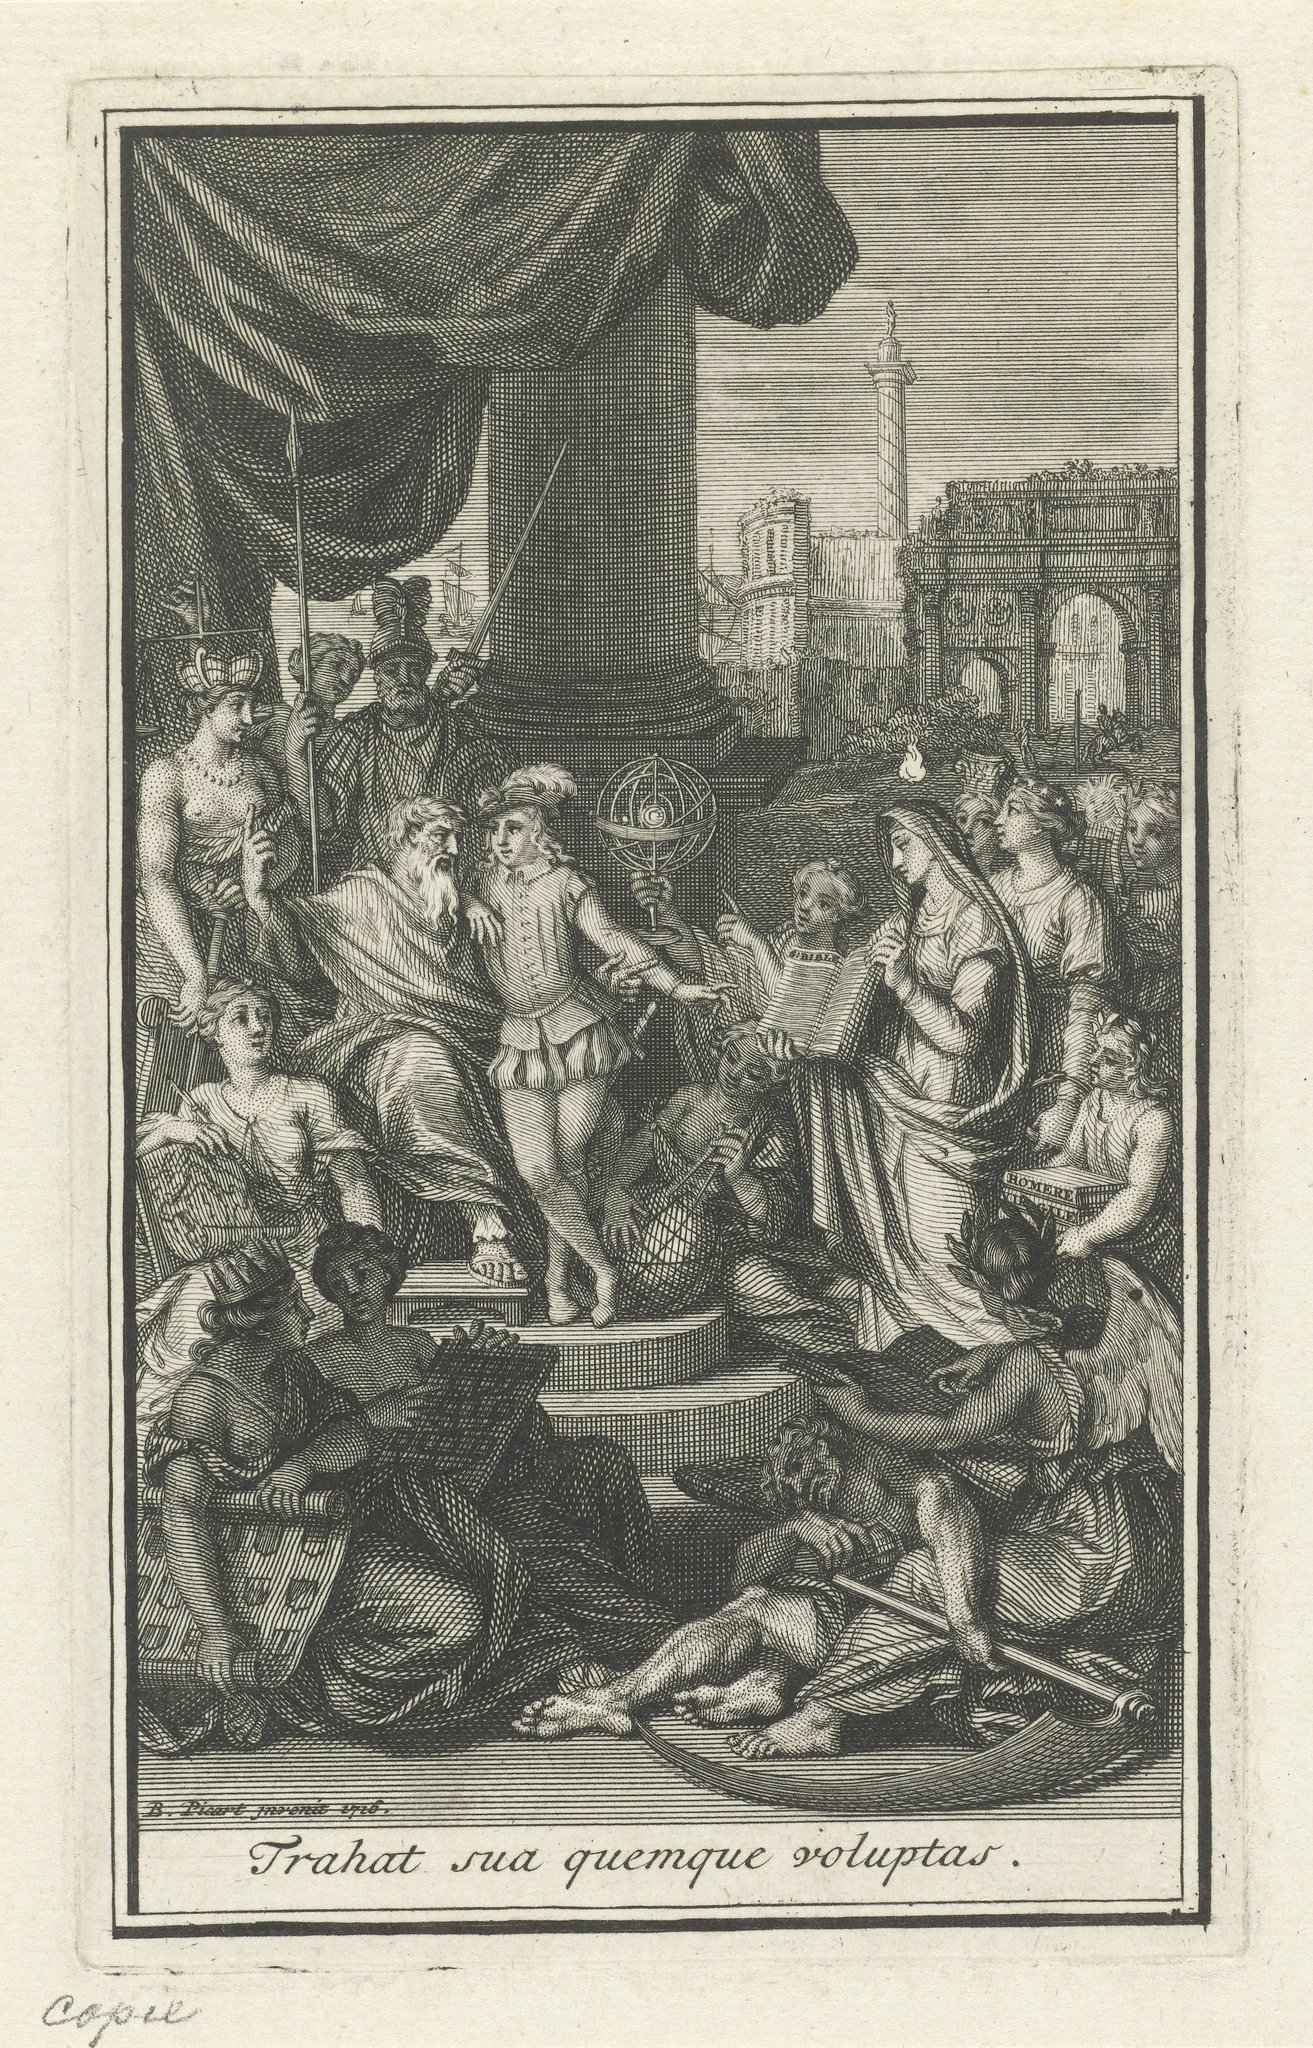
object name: print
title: Trahat sua quemque voluptas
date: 1716-1817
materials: paper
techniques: etching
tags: throne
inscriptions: collector's mark: Lugt 240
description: Een tronende bebaarde man en een jongeman naast hem worden omringd door een groep allegorische figuren. Bijna alle figuren hebben hun blik op dit tweetal gericht, enkelen willen de jongeman iets tonen of aanbieden. Astronomia biedt hem een armillarium aan en Religio toont hem de Bijbel.